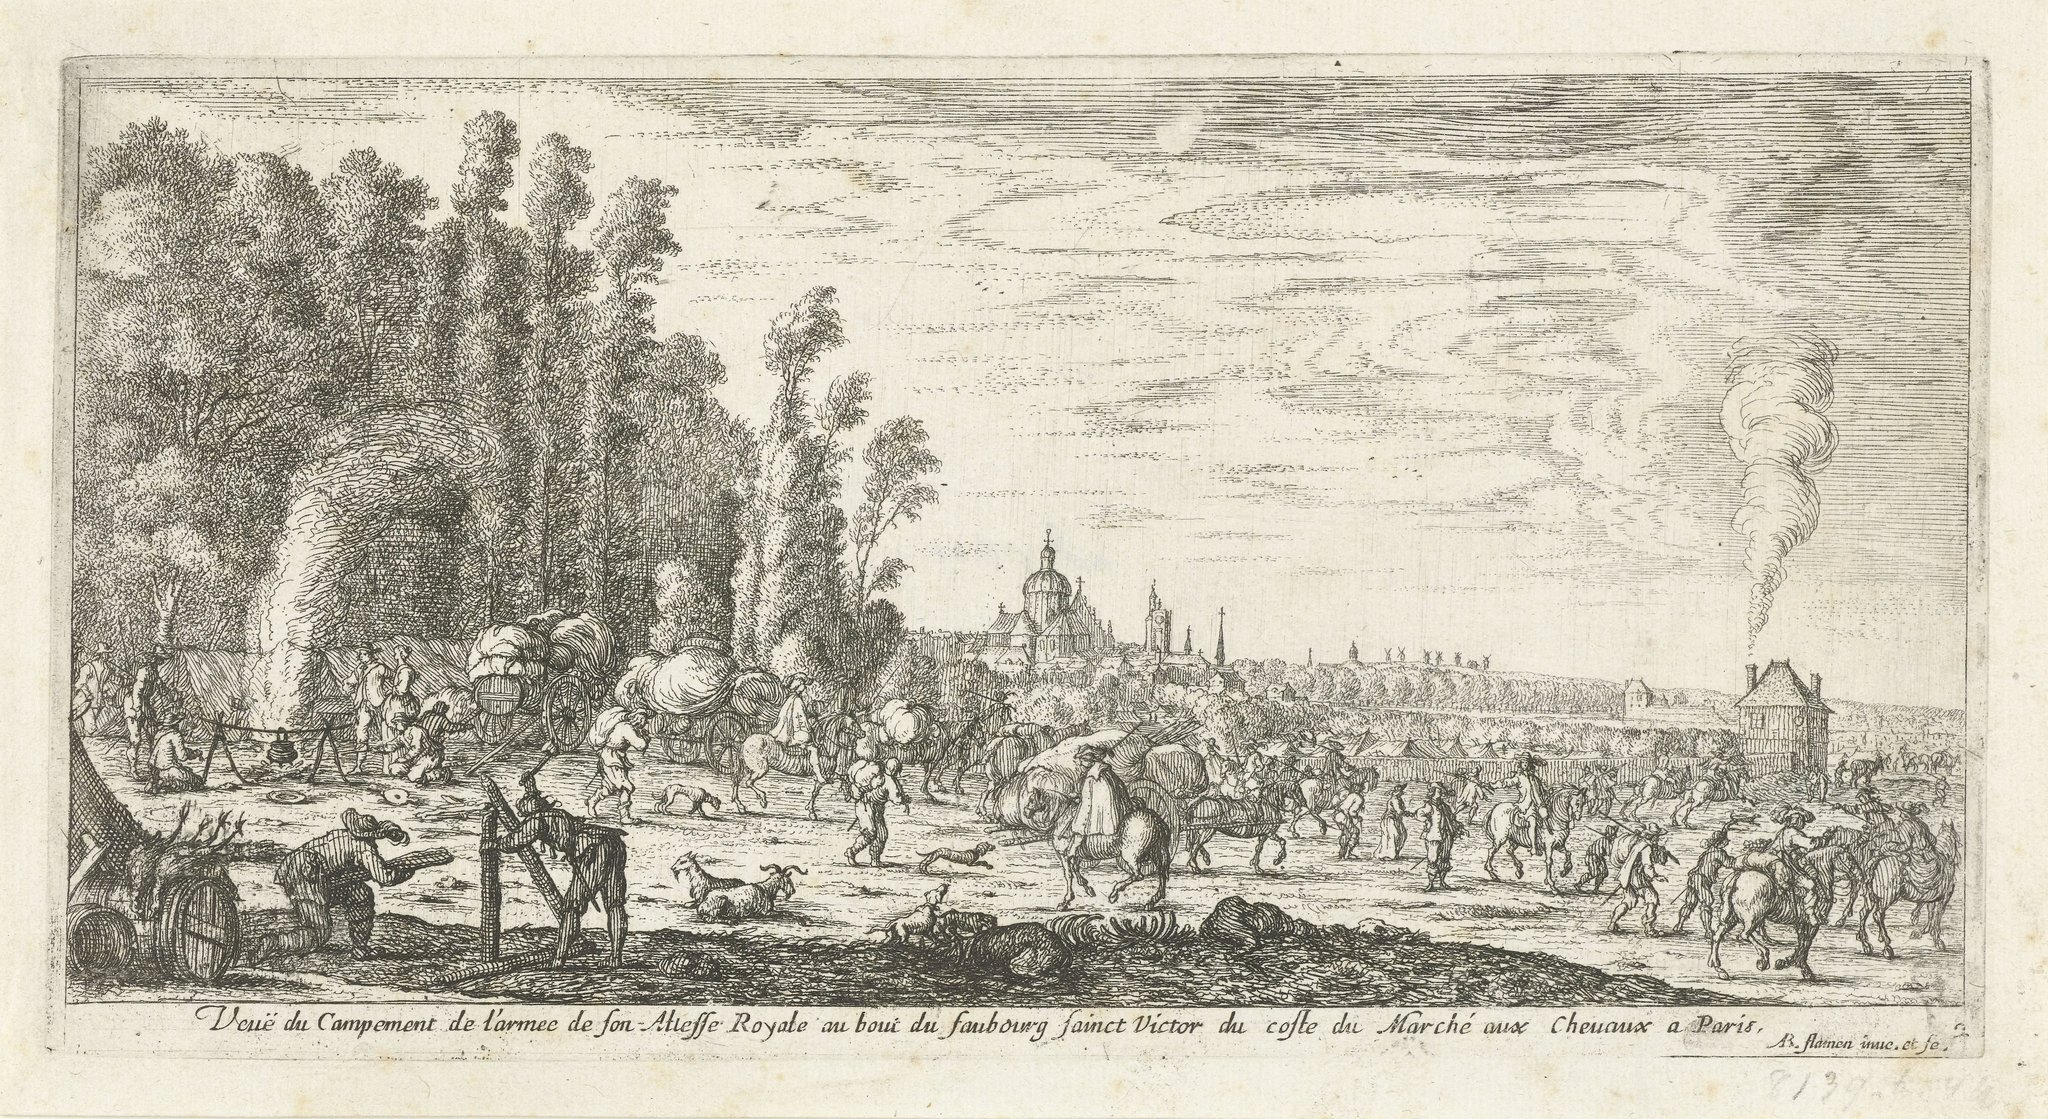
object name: print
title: Landschappen, landhuizen en kastelen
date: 1648-1672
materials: paper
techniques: etching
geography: france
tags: (military) camp with tents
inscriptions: collector's mark: Lugt 2161, signature: Lugt 269, collector's mark: Lugt 2228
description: Gezicht op soldaten te voet en te paard tijdens het opbouwen van een tentenkamp. Op de achtergrond de St. Victor kerk, nabij Parijs.